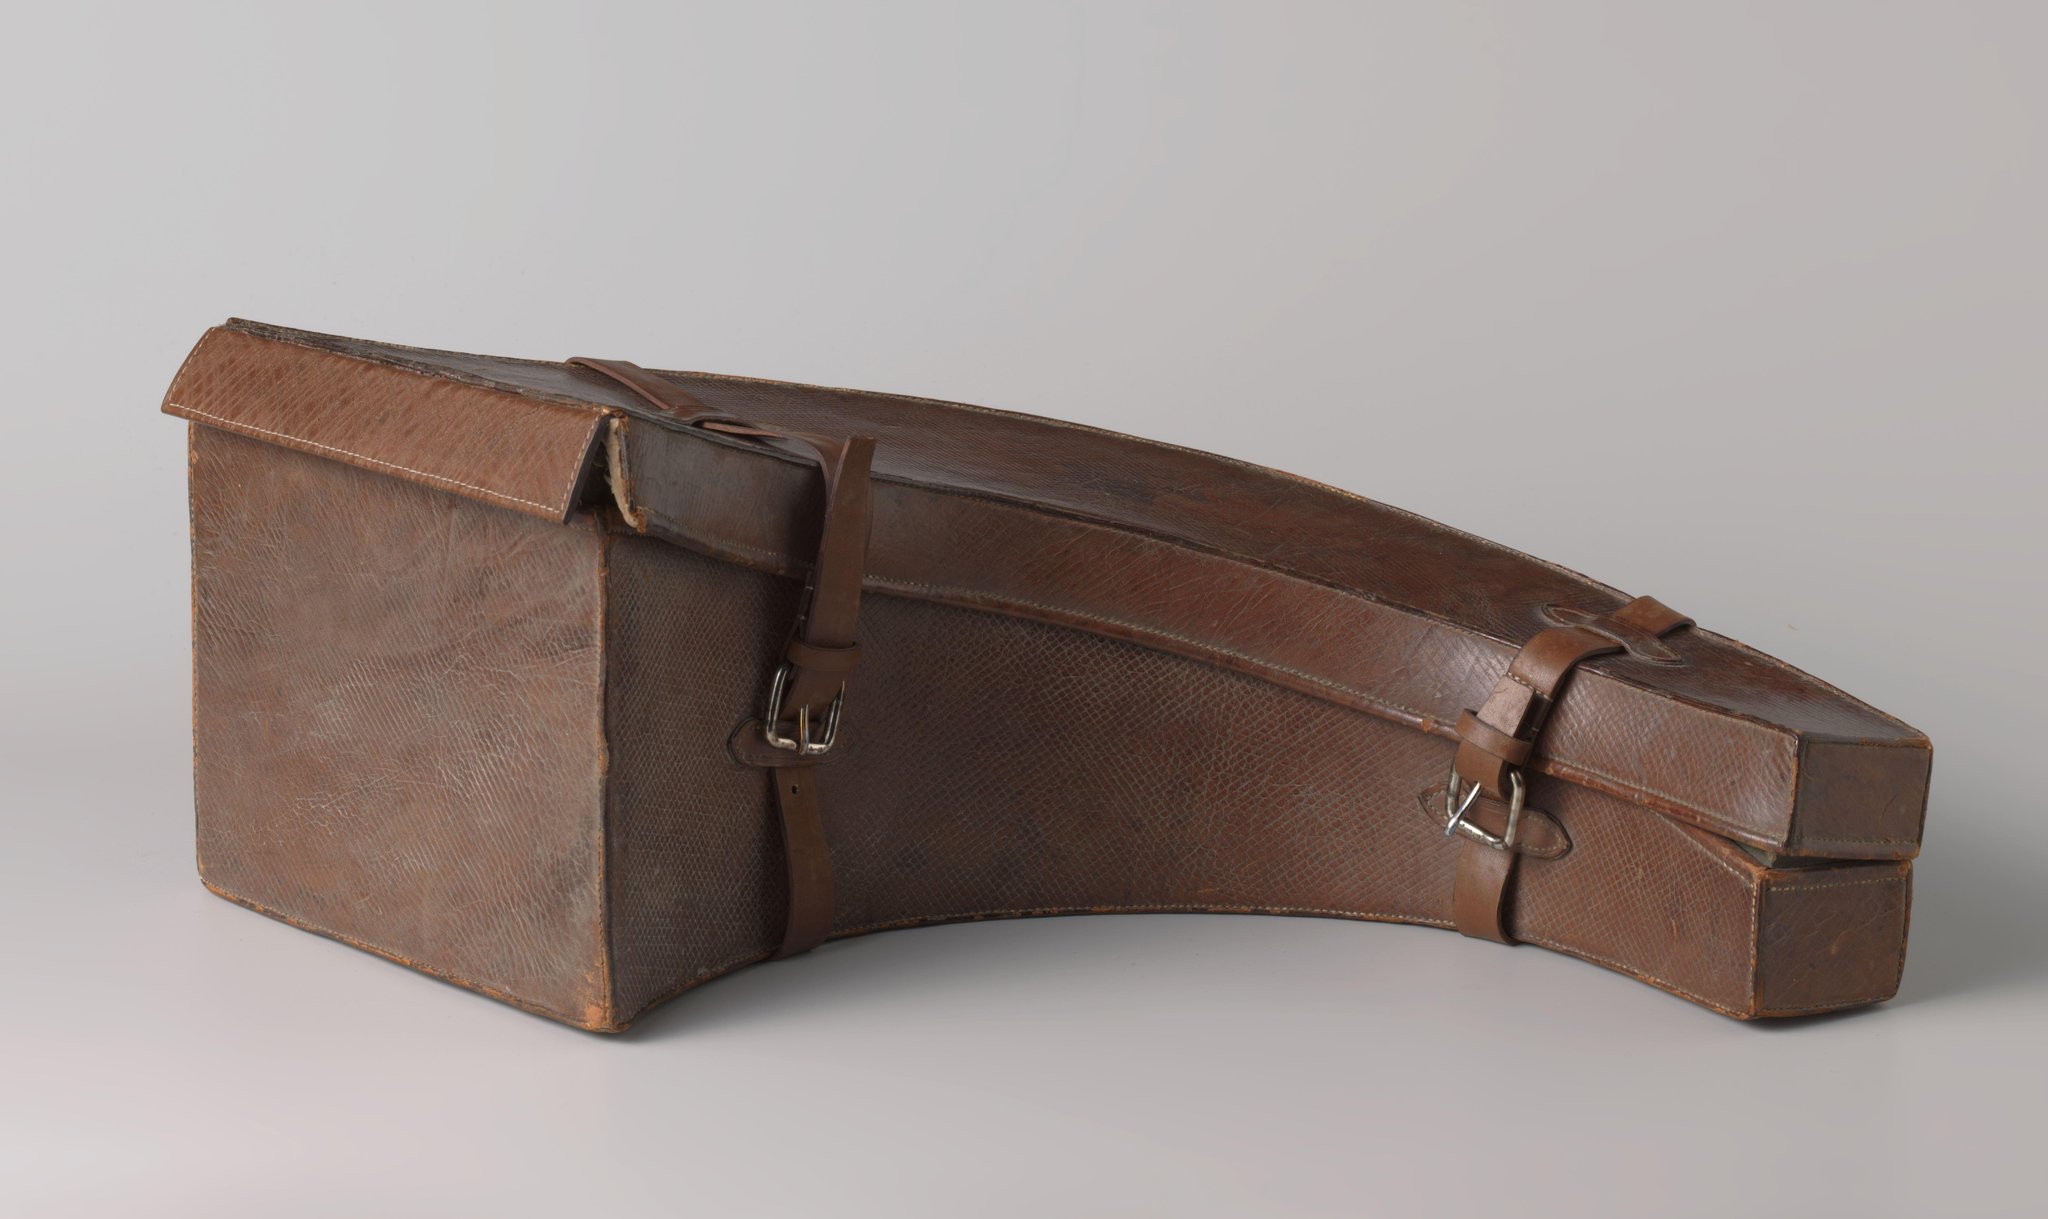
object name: case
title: Foedraal van een jachthoorn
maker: johannes mattheus van kempen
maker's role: silversmith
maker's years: 1814-1877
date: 1849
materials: leather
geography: utrecht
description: Foedraal van een jachthoorn (BK-2016-11-1).